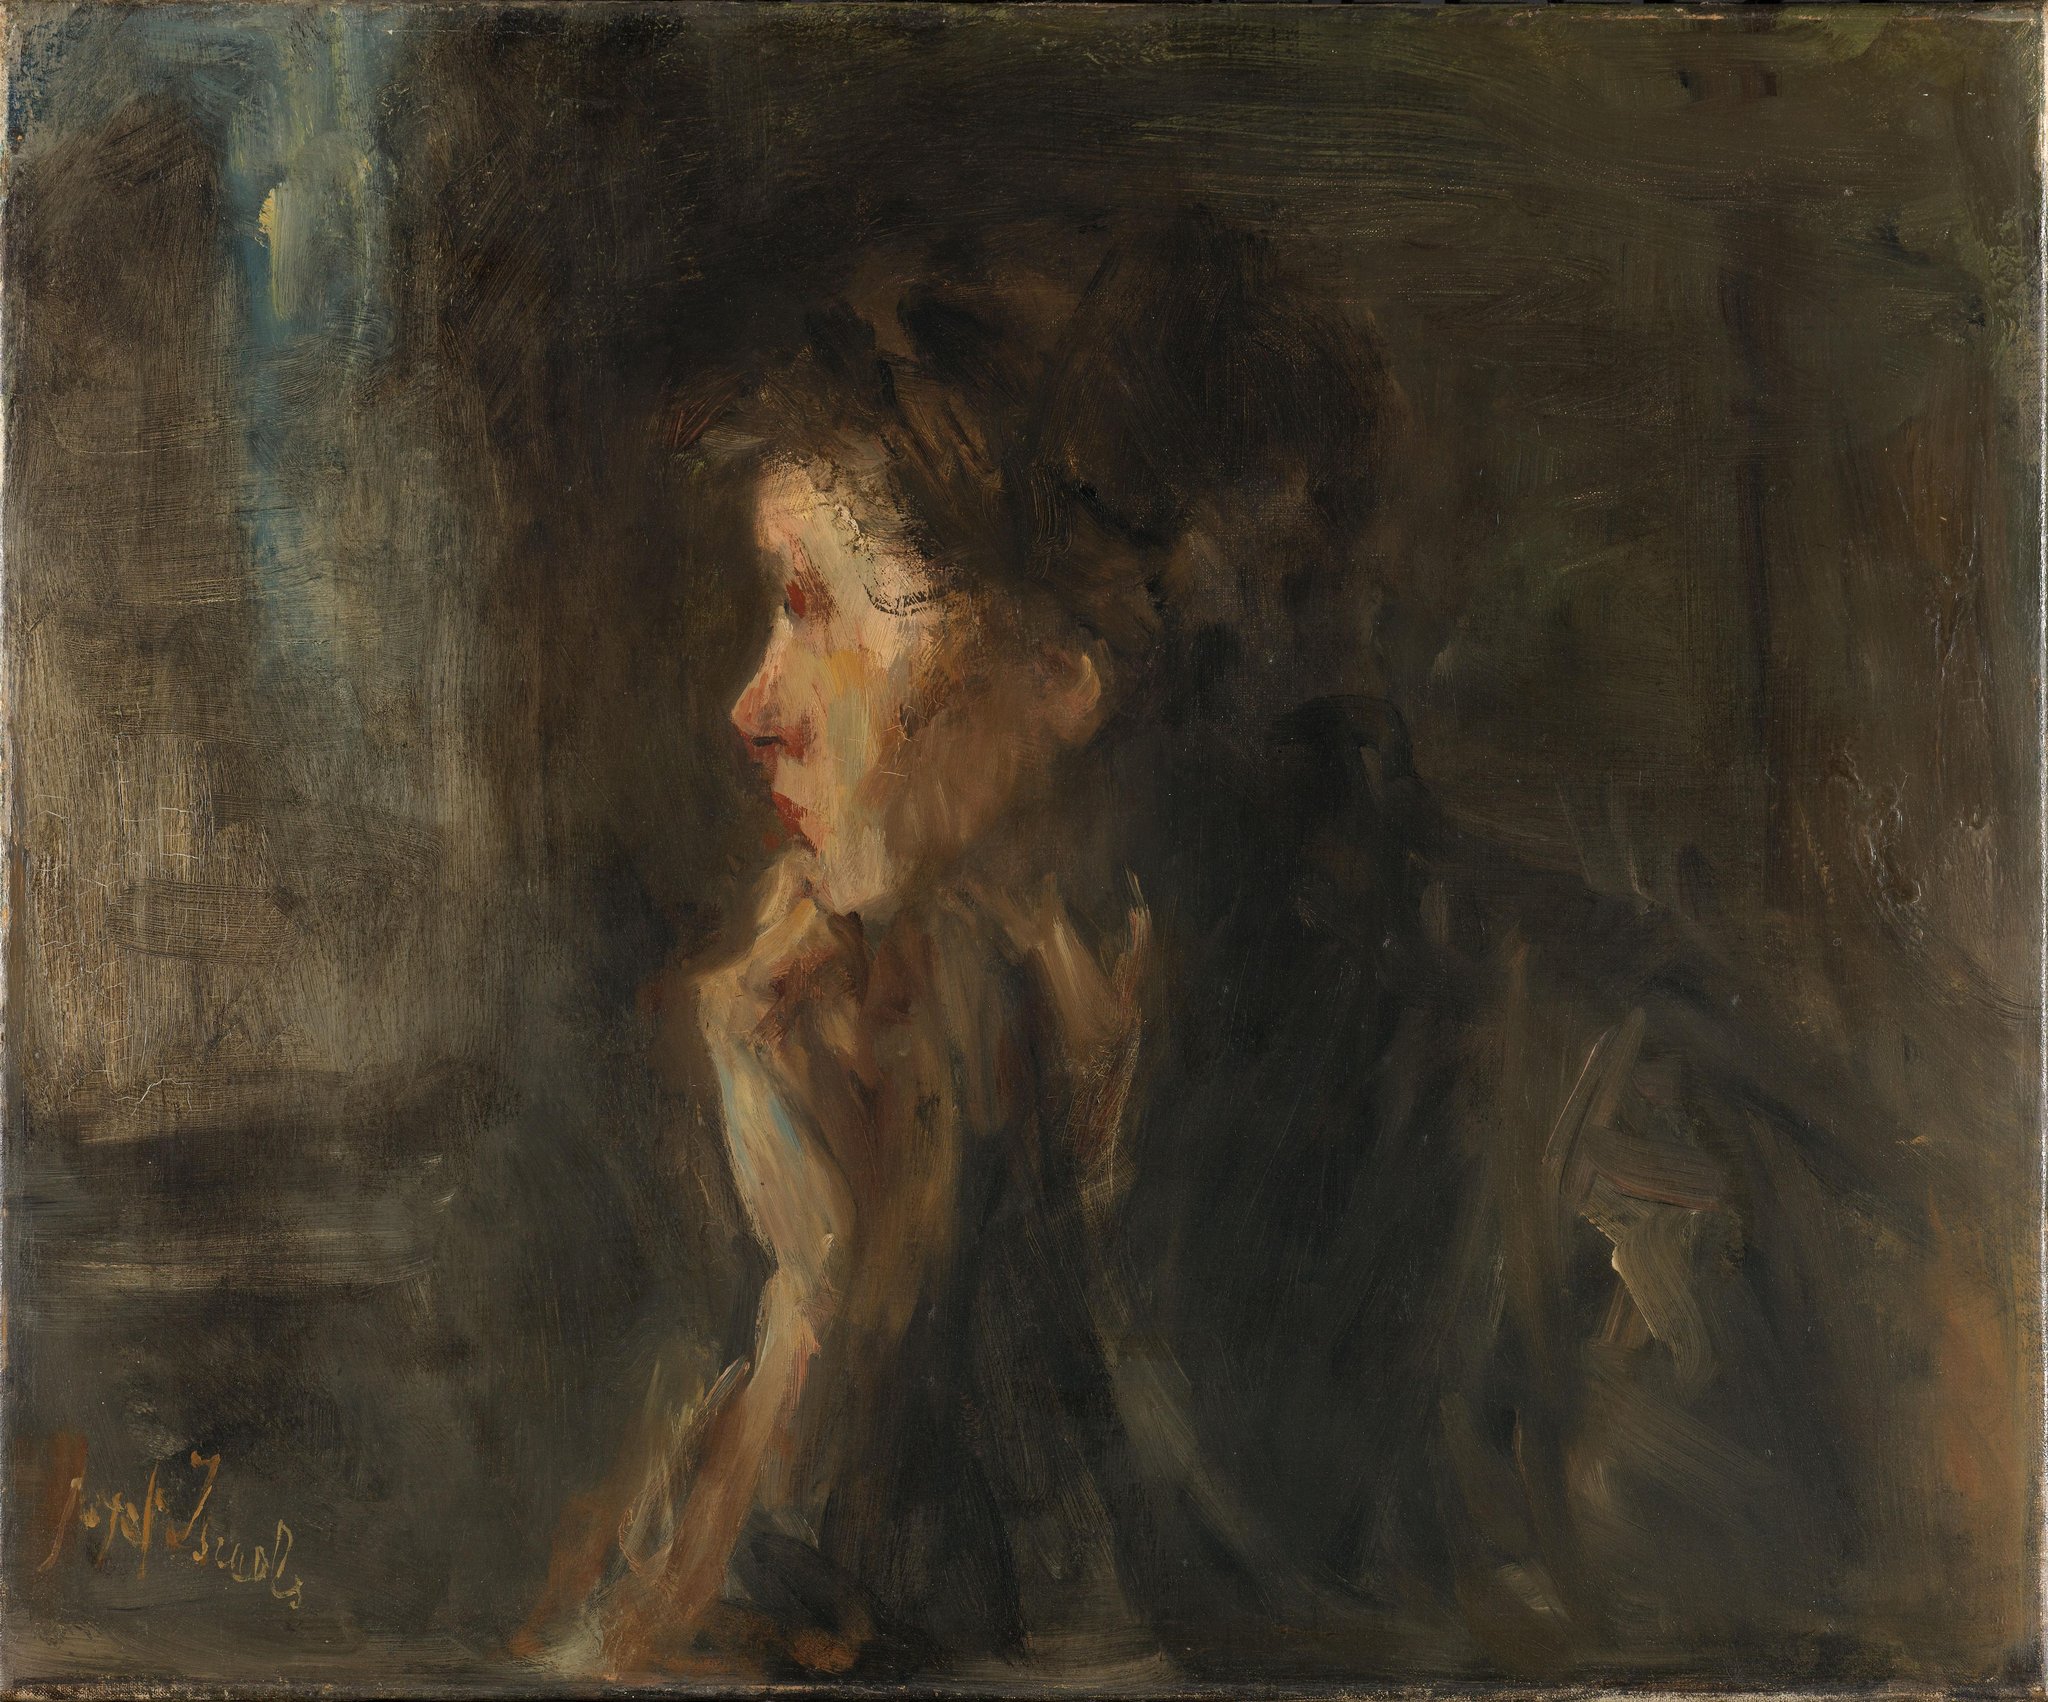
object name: painting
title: 'Meditation'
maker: jozef israëls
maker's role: draughtsman, painter, print maker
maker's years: 1824-1911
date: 1896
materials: canvas, oil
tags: adult woman, human figure at (open) window, seen from inside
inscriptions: signature: ‘Jozef Israels’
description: 'Overpeinzing'. Buste van een jonge vrouw, de rechterhand tegen de kin, peinzend uit een raam starend.